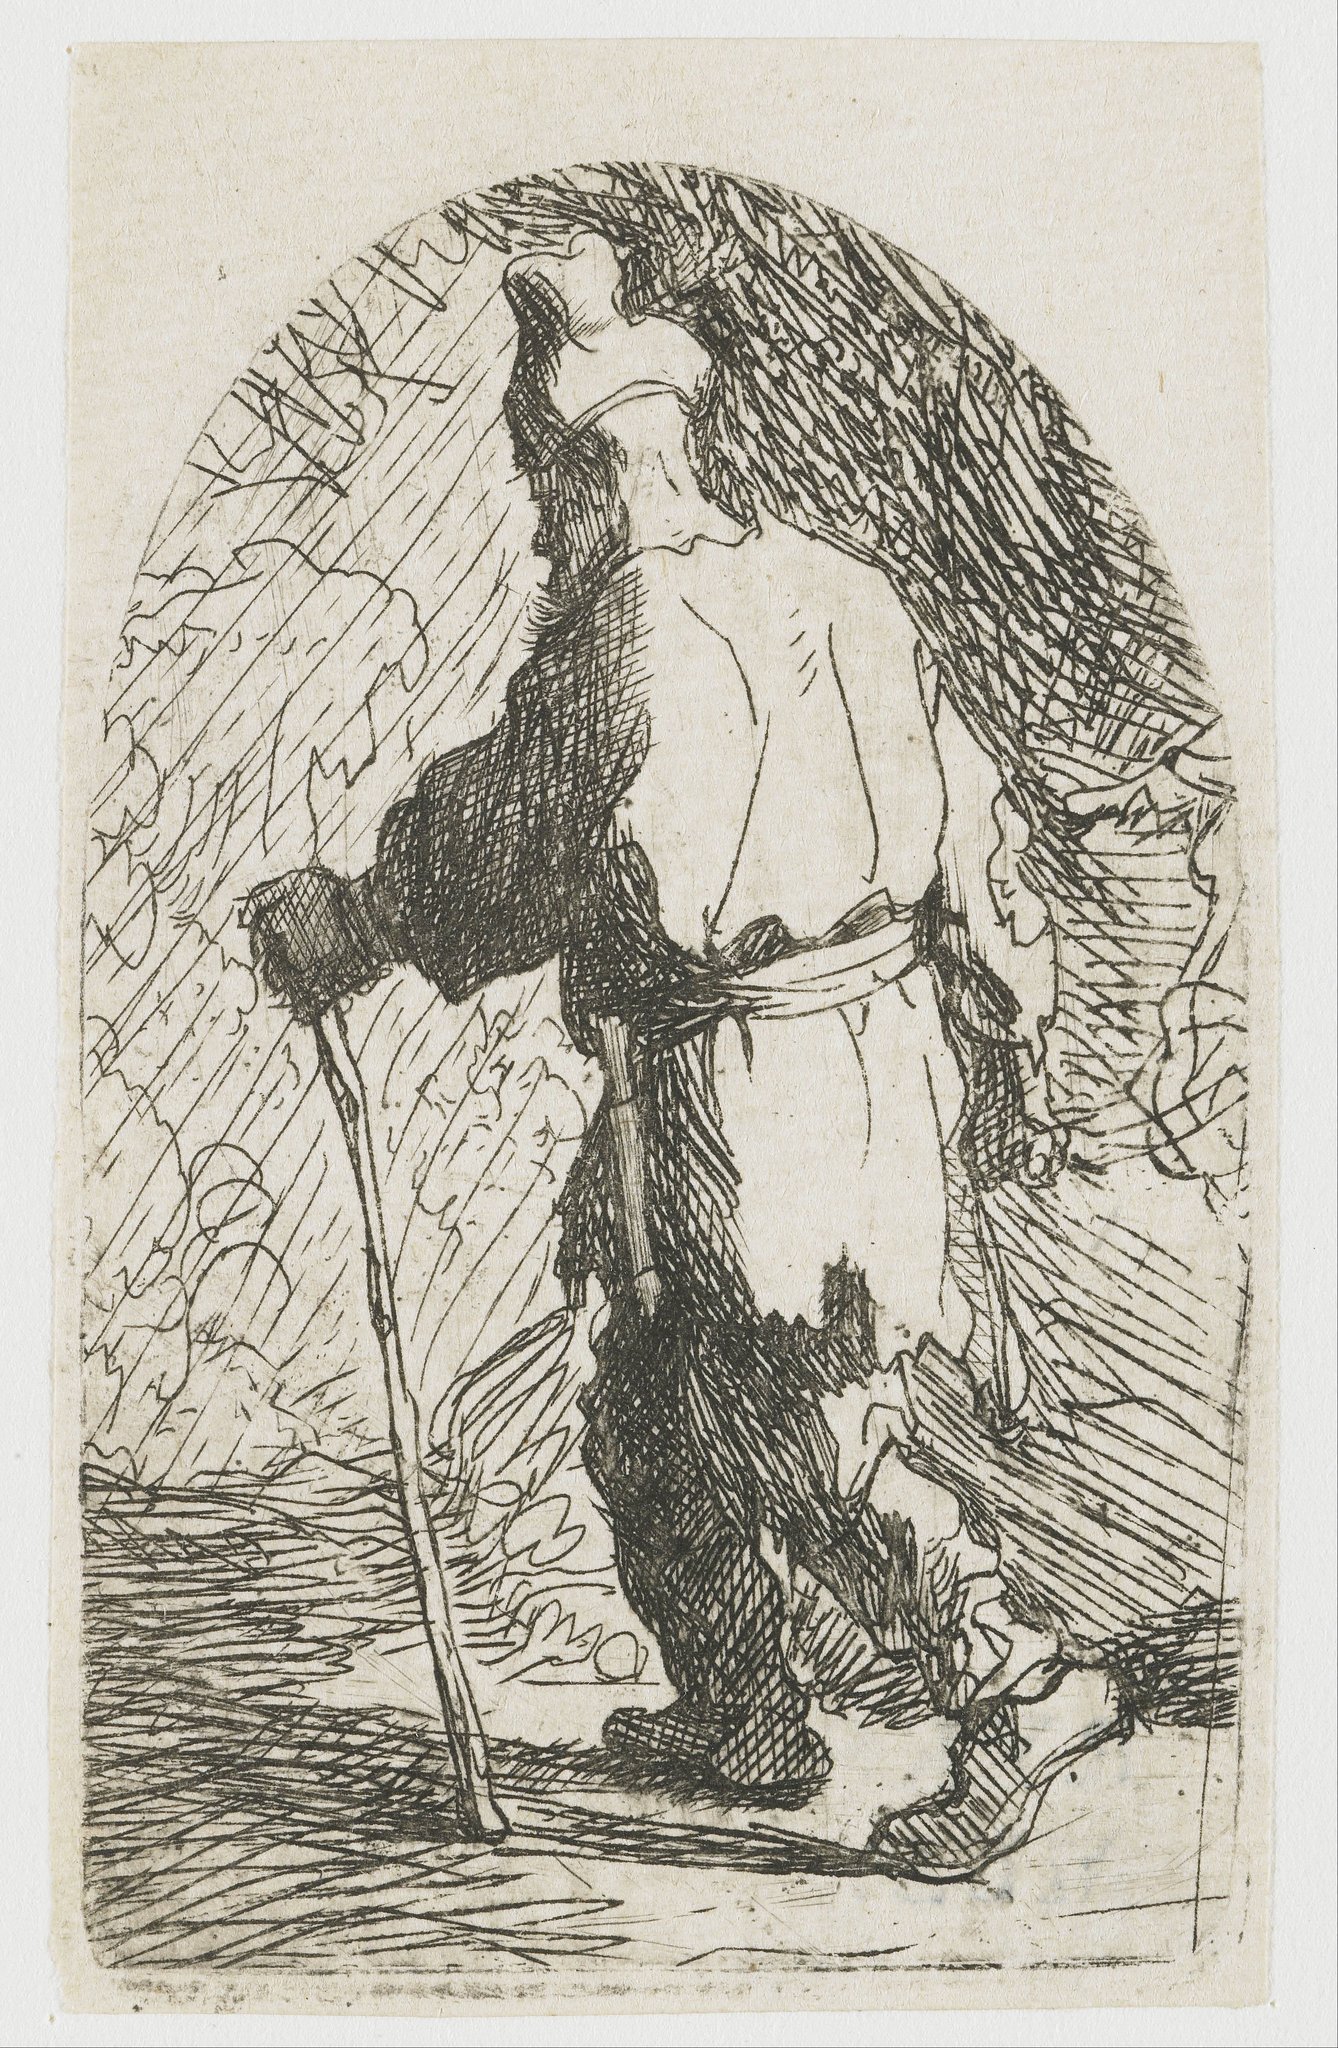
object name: print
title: The flight into Egypt: a sketch: St Joseph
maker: rembrandt van rijn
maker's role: draughtsman, painter, print maker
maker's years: 1606-1669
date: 1628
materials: paper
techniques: etching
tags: the flight into egypt: mary, joseph, the child (and sometimes others) on their way; mary usually riding on an ass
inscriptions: mark: Lugt 2165